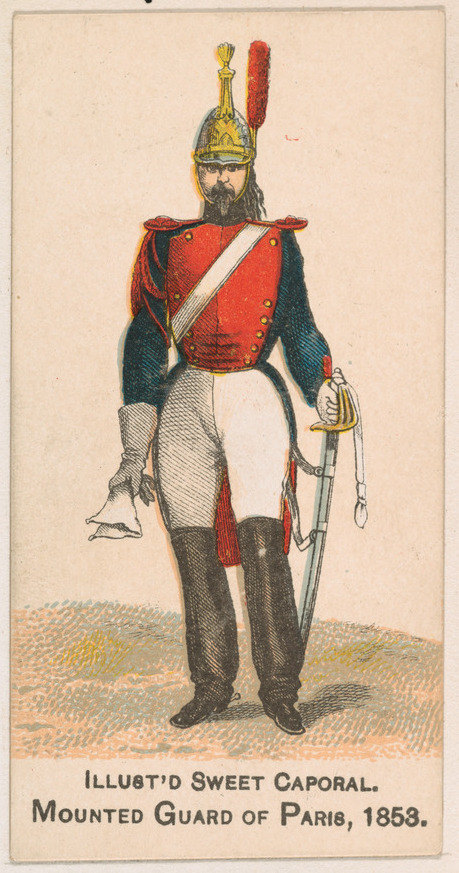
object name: print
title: Mounted Guard of Paris, 1853, from the Military Series (N224) issued by Kinney Tobacco Company to promote Sweet Caporal Cigarettes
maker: kinney brothers tobacco company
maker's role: publisher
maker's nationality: american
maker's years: 1869-2011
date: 1888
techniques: color lithograph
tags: military,men